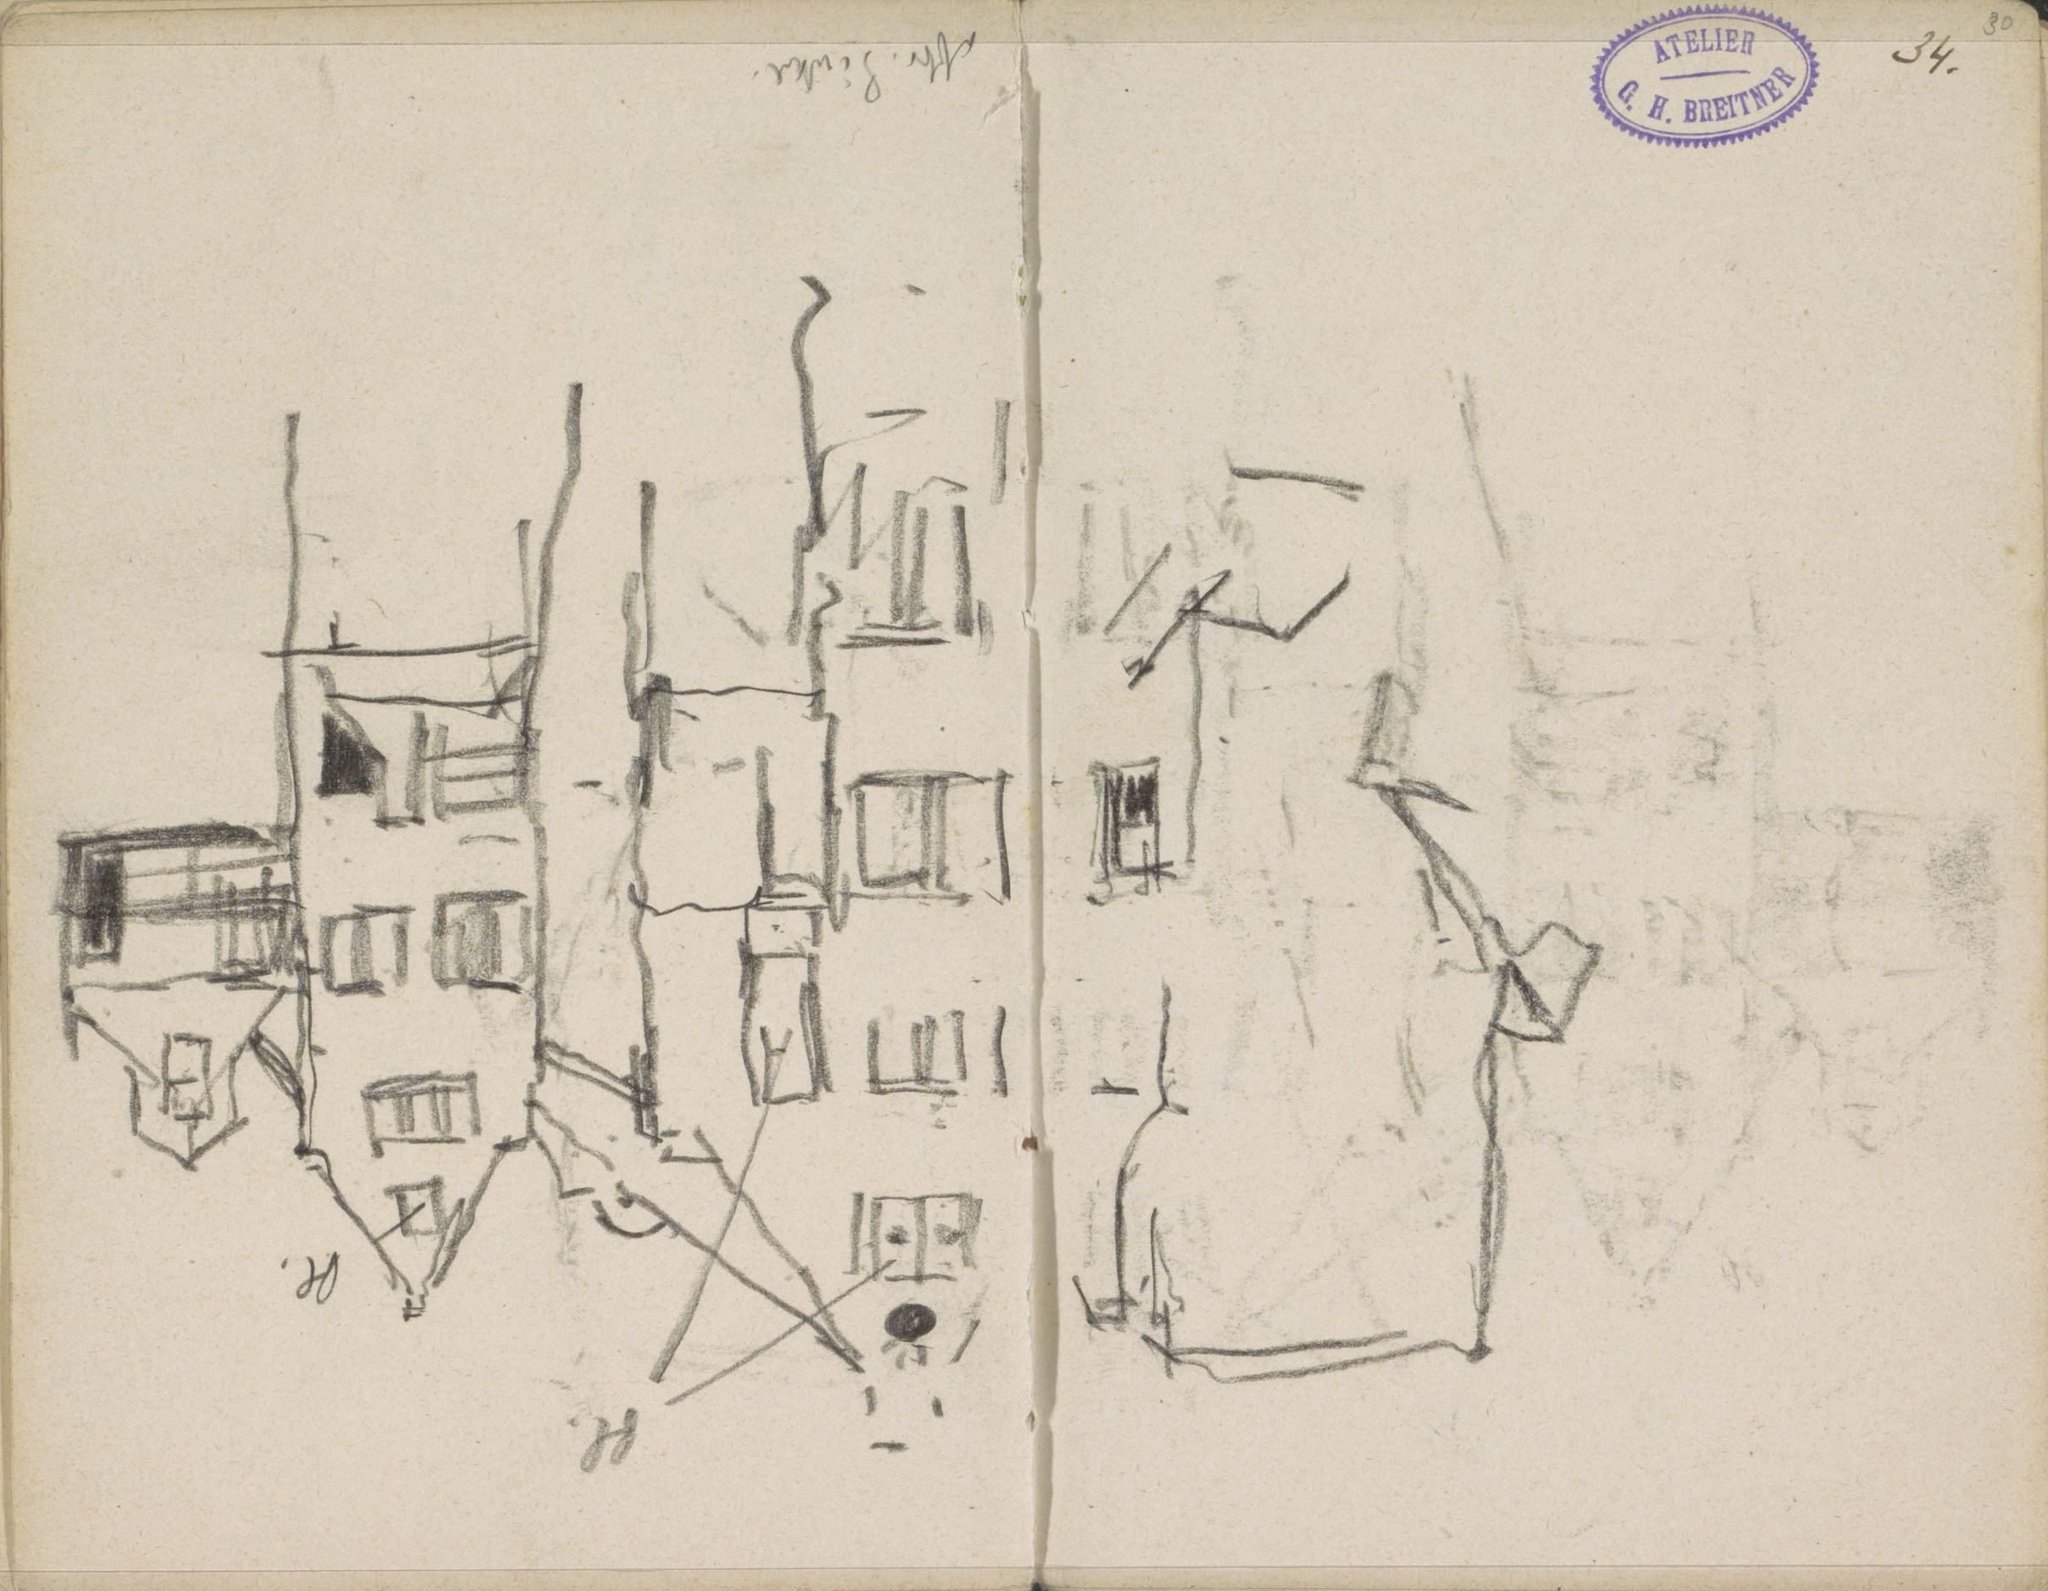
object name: sketchbook leaf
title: Afbraak van de Winkel van Sinkel op de Nieuwendijk te Amsterdam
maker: george hendrik breitner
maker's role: draughtsman, painter, print maker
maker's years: 1857-1923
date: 1912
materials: chalk, paper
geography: amsterdam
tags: shop, store, demolition of building, civic architecture; edifices; dwellings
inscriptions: workshop stamp: Lugt 291d, annotation: ‘afbr. Sinkel.’, :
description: Pagina 29 en pagina 30 uit een schetsboek met 16 bladen.